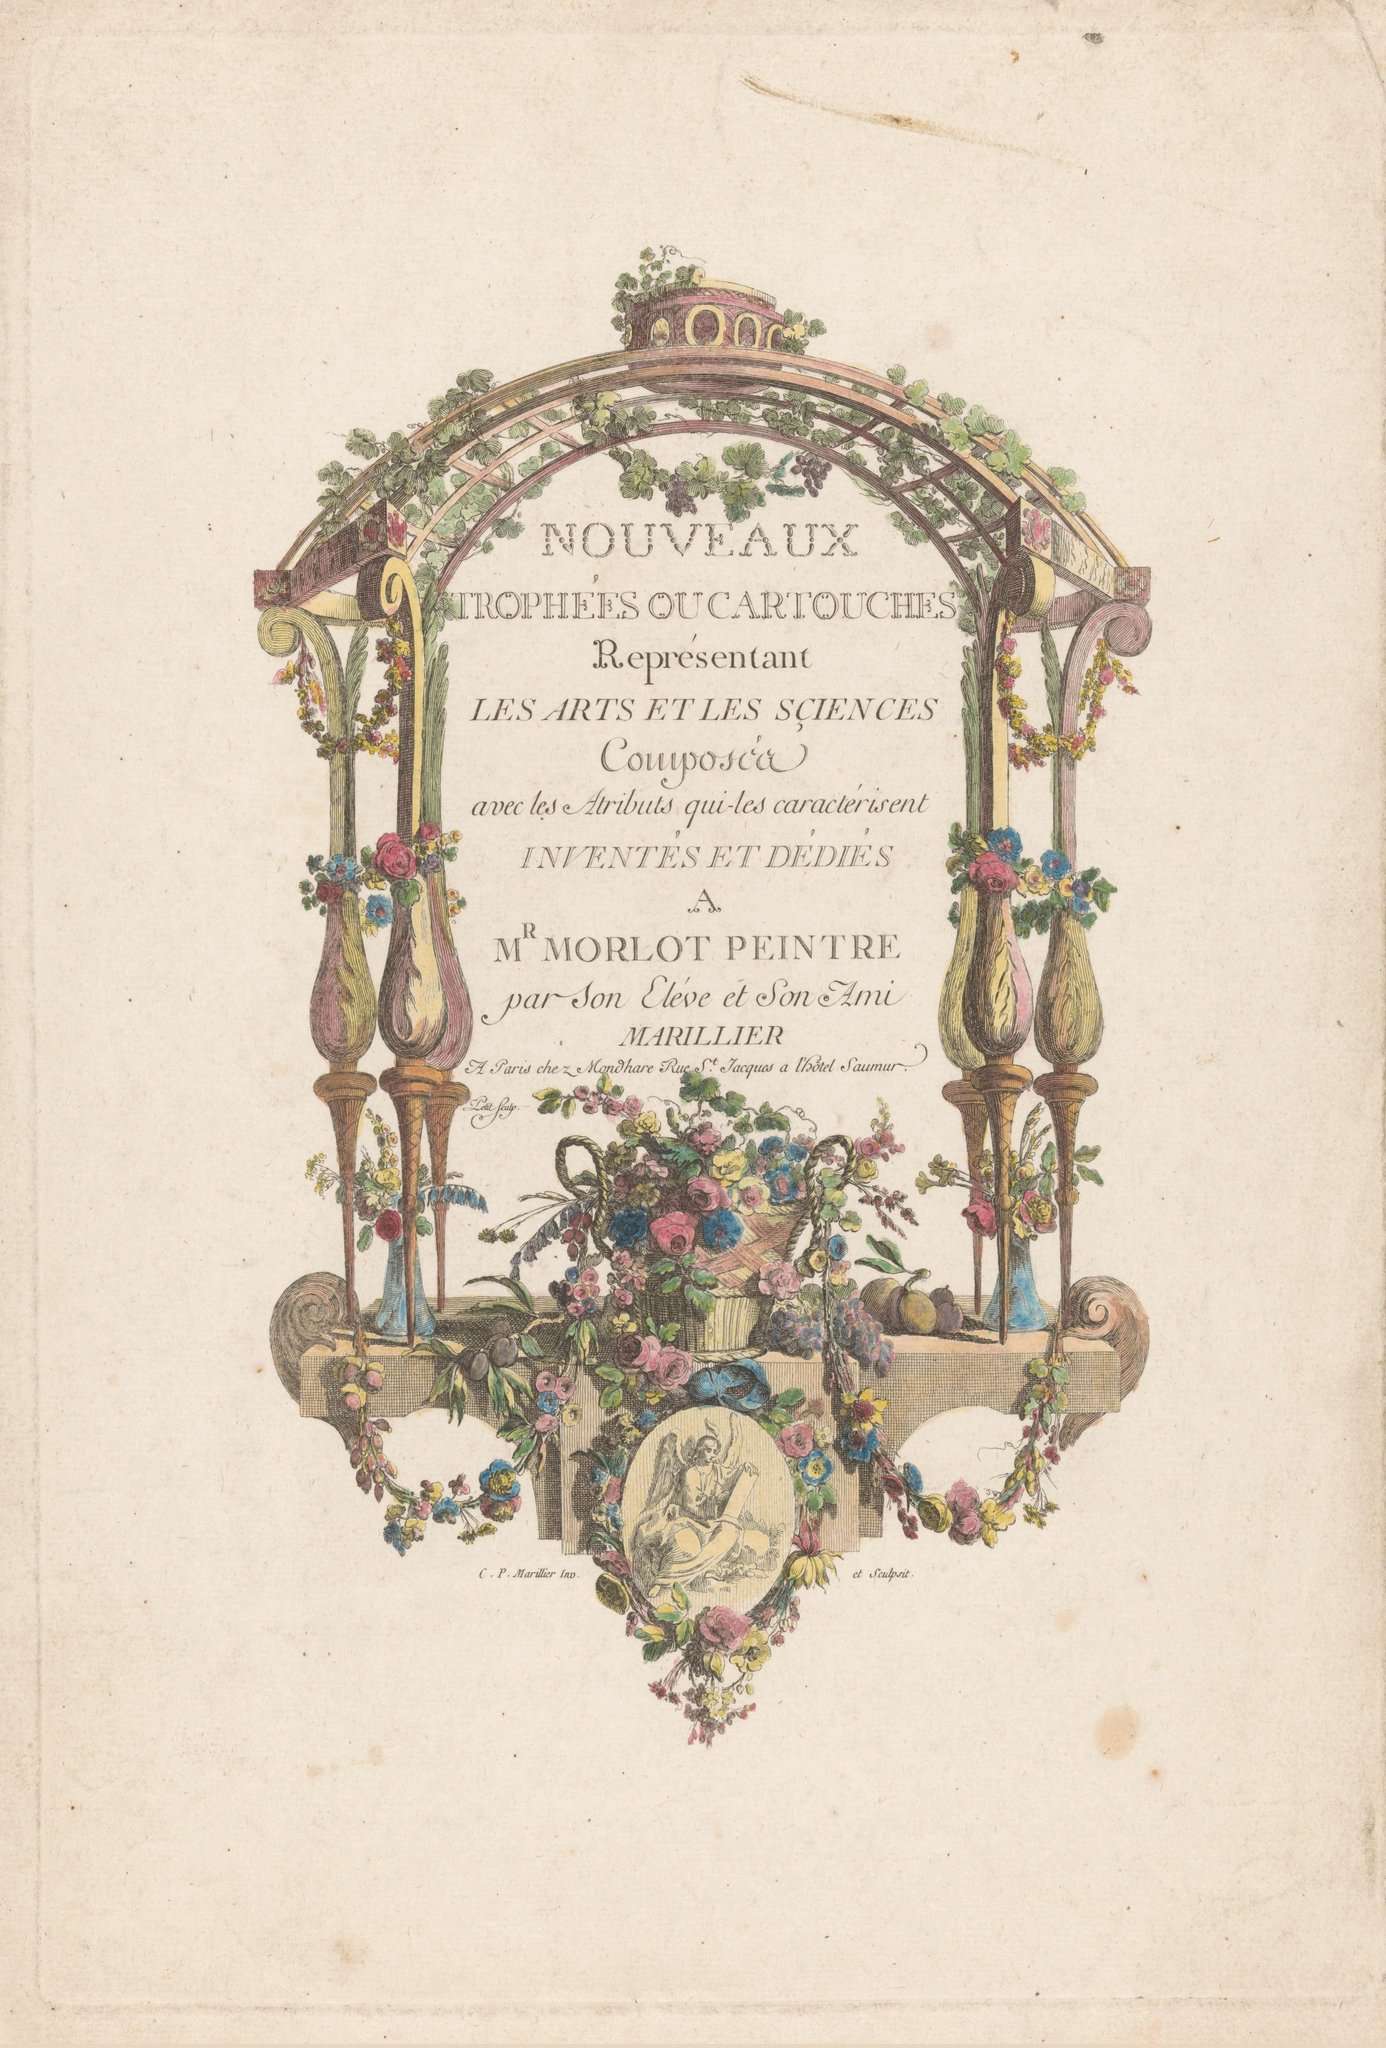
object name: ornament print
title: Pergola met bloemenmand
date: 1760-1784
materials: paper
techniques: etching, hand coloring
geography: paris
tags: cut flowers; nosegay, bunch of flowers, pergola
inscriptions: collector's mark: Lugt 2760, collector's mark: Lugt 2228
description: Onder een pergola met druivenranken staat een mand met bloemen op een plateau. Op het plateau een ovaal medaillon met een engel. Boven de mand de serietitel.